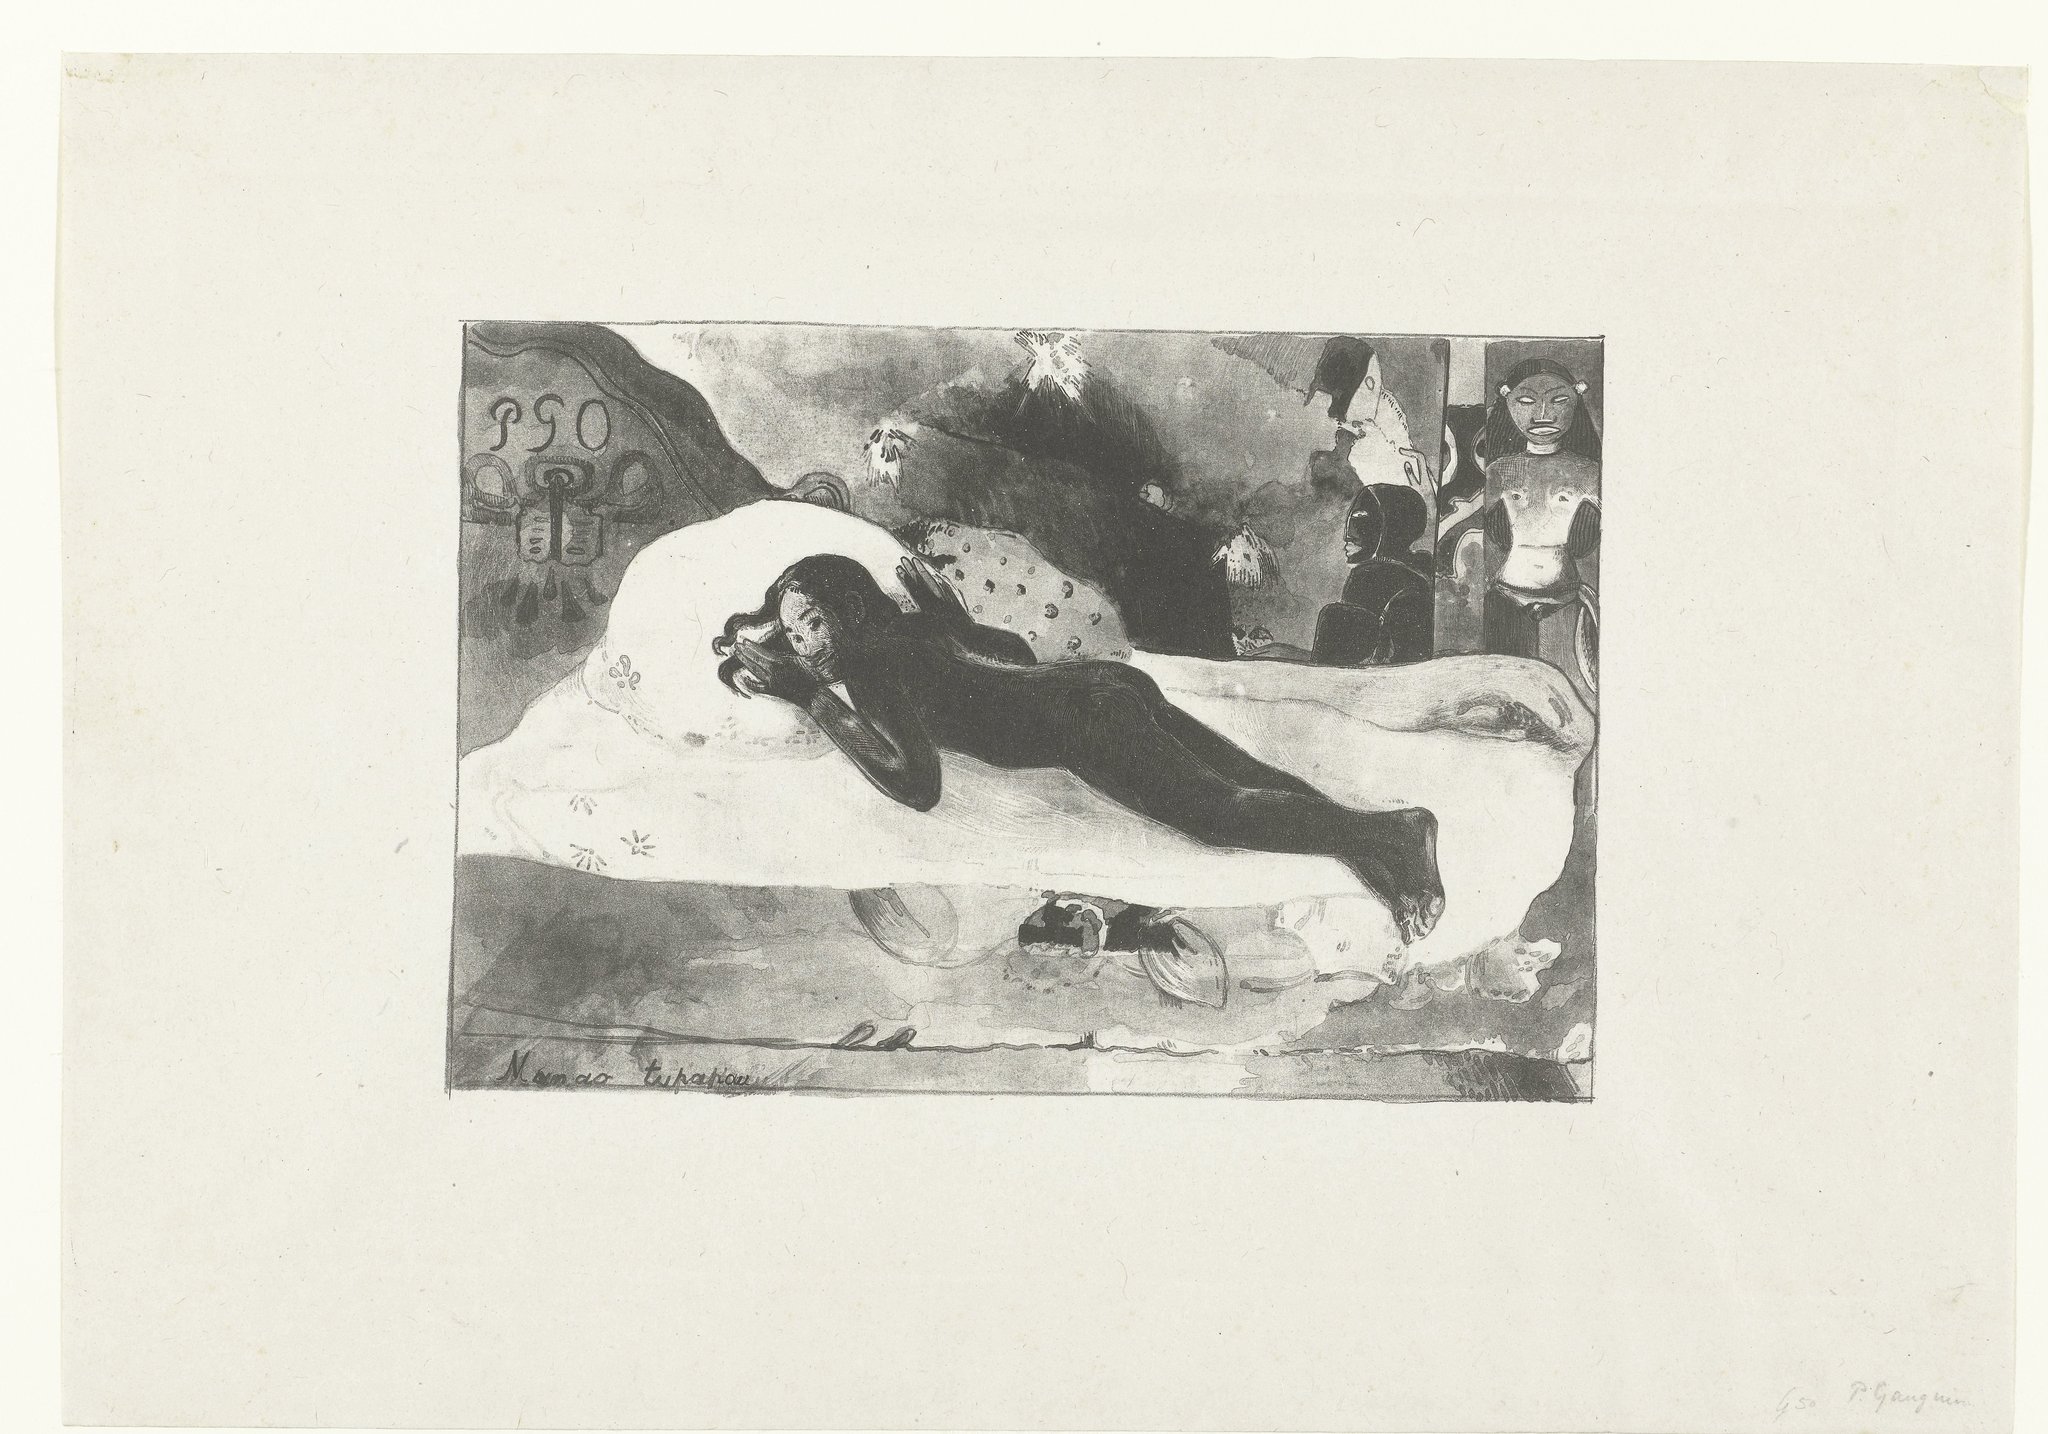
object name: print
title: Manao tupapau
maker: paul gauguin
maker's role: draughtsman, print maker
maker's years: 1848-1903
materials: paper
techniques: lithograph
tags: tahiti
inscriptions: collector's mark: Lugt 2228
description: Liggend meisje op een kleed is bang voor de geesten van overledenen die achter haar zijn weergegeven.